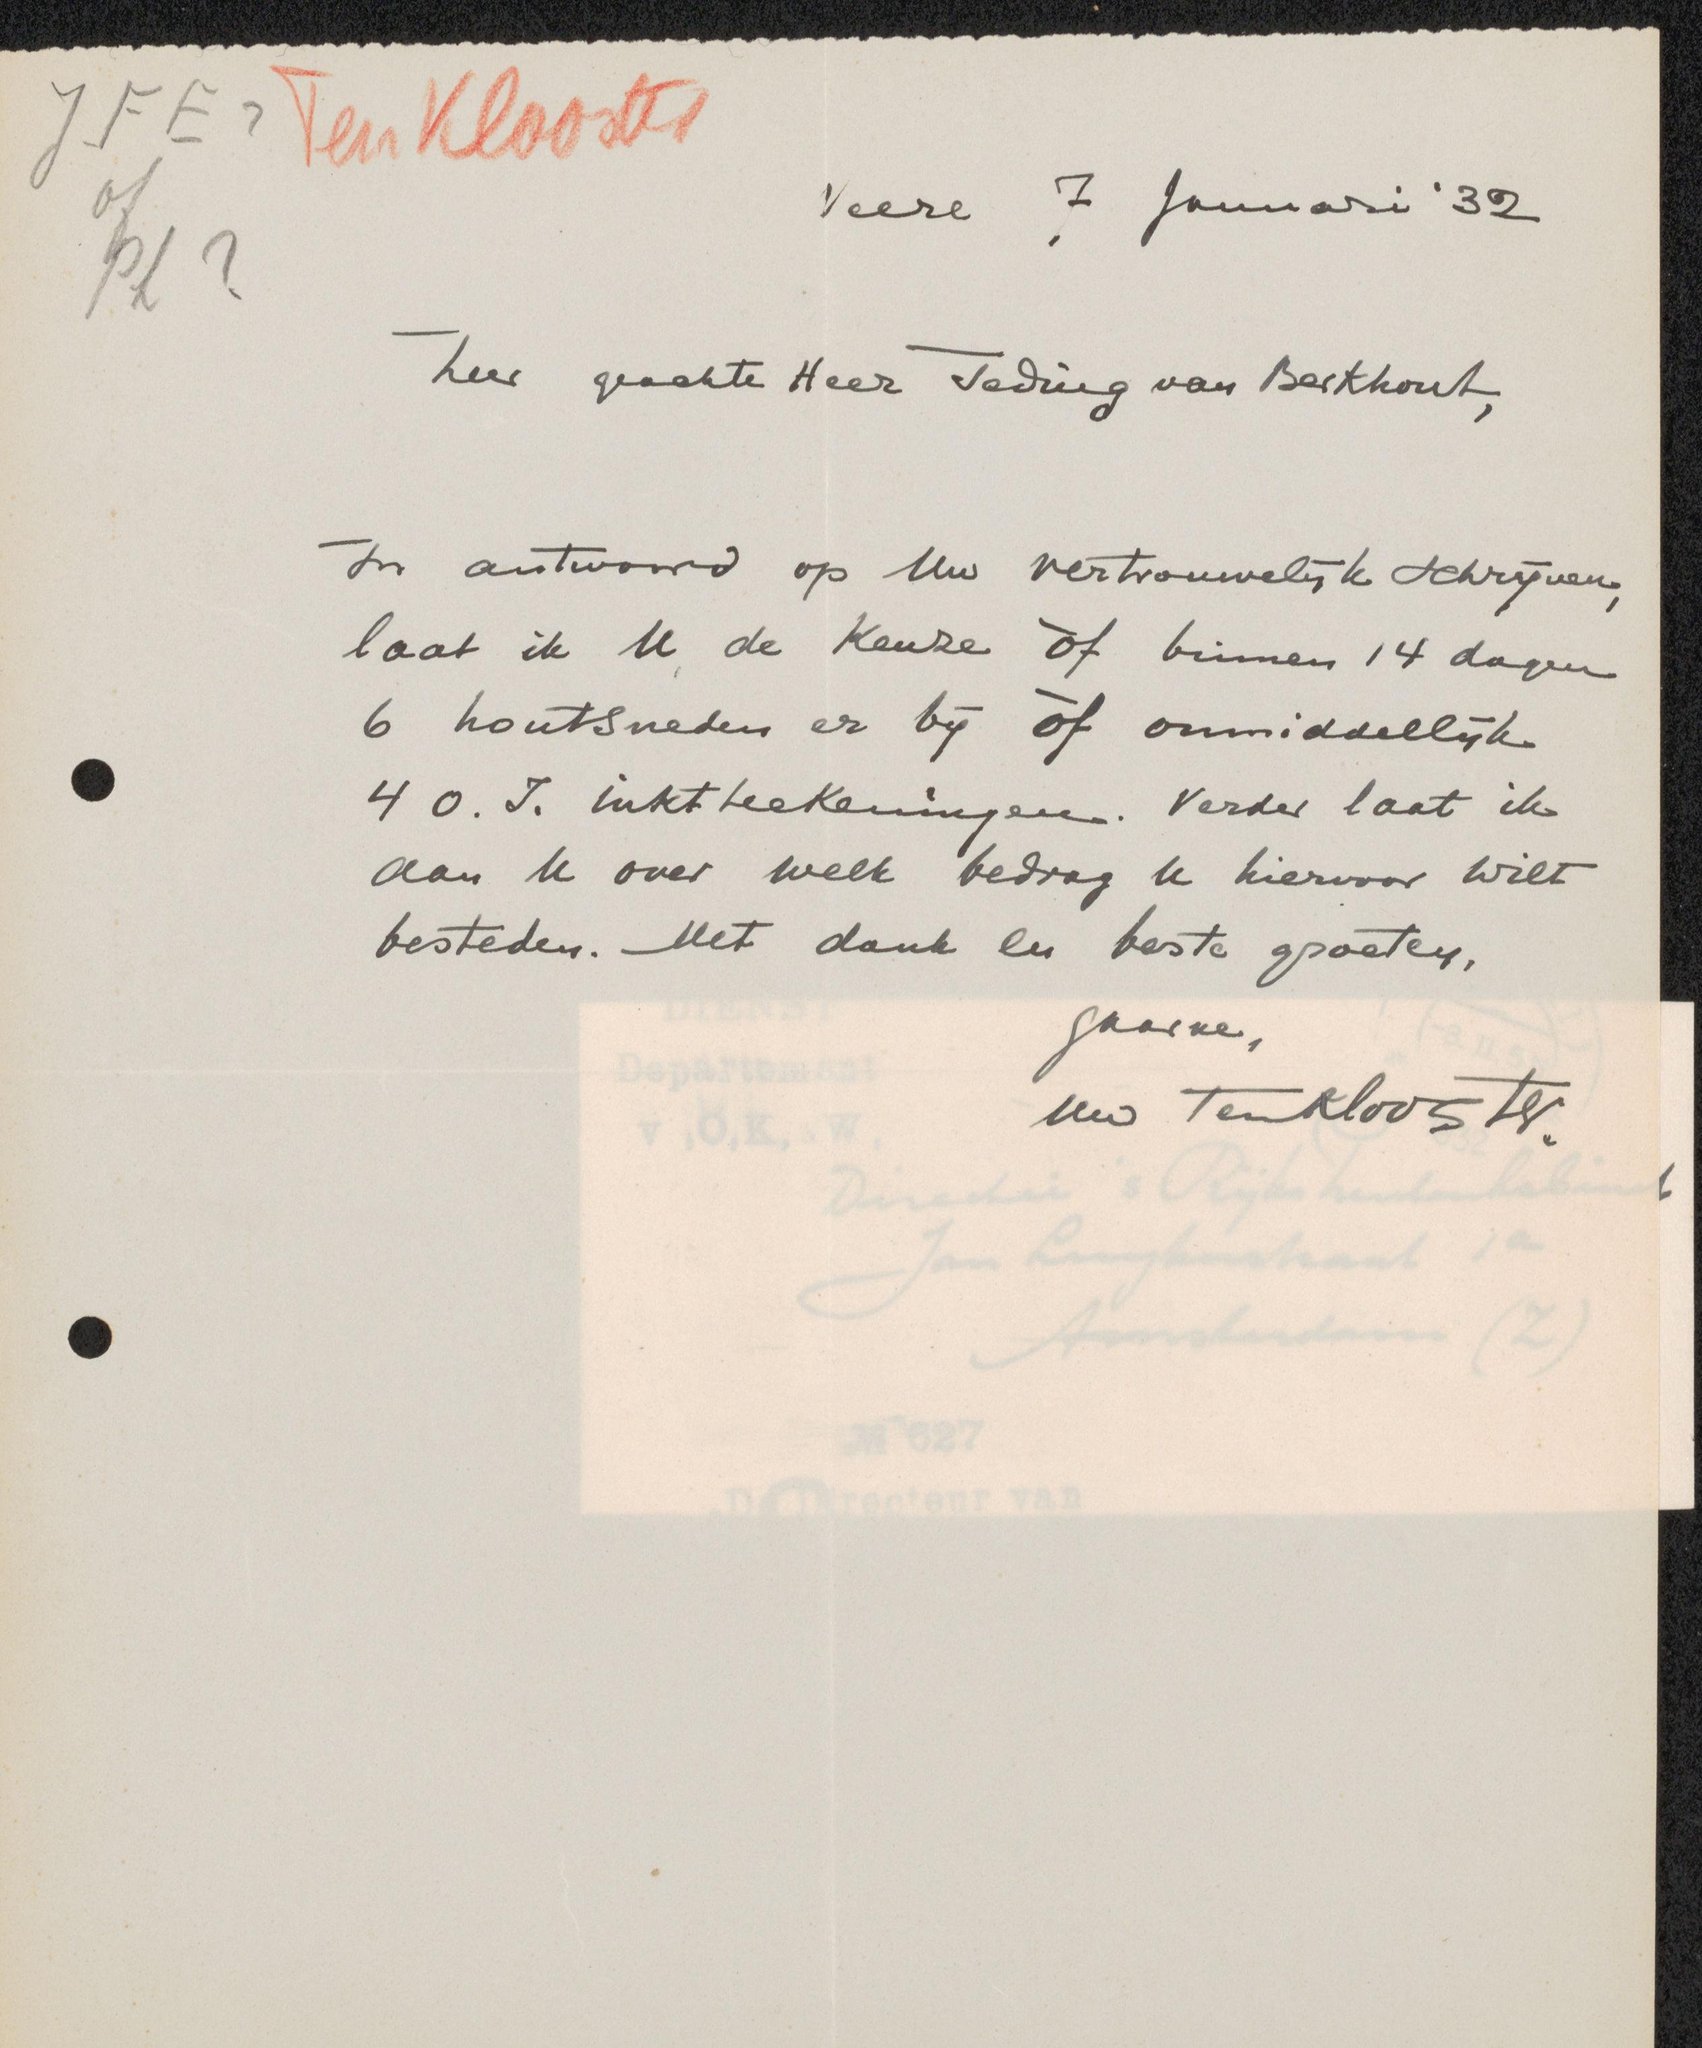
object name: letter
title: Brief aan jonkheer Hendrik Teding van Berkhout (1879-1969)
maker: johannes frederik engelbert ten klooster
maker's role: draughtsman, print maker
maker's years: 1873-1940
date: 1932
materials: ink, paper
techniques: pen, writing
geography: veere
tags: haarlem, amsterdam, jonkheer hendrik teding van berkhout (1879-1969), drawing, the graphic arts, money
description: Brief bevat briefkaart betreffende teruggezonden werken.